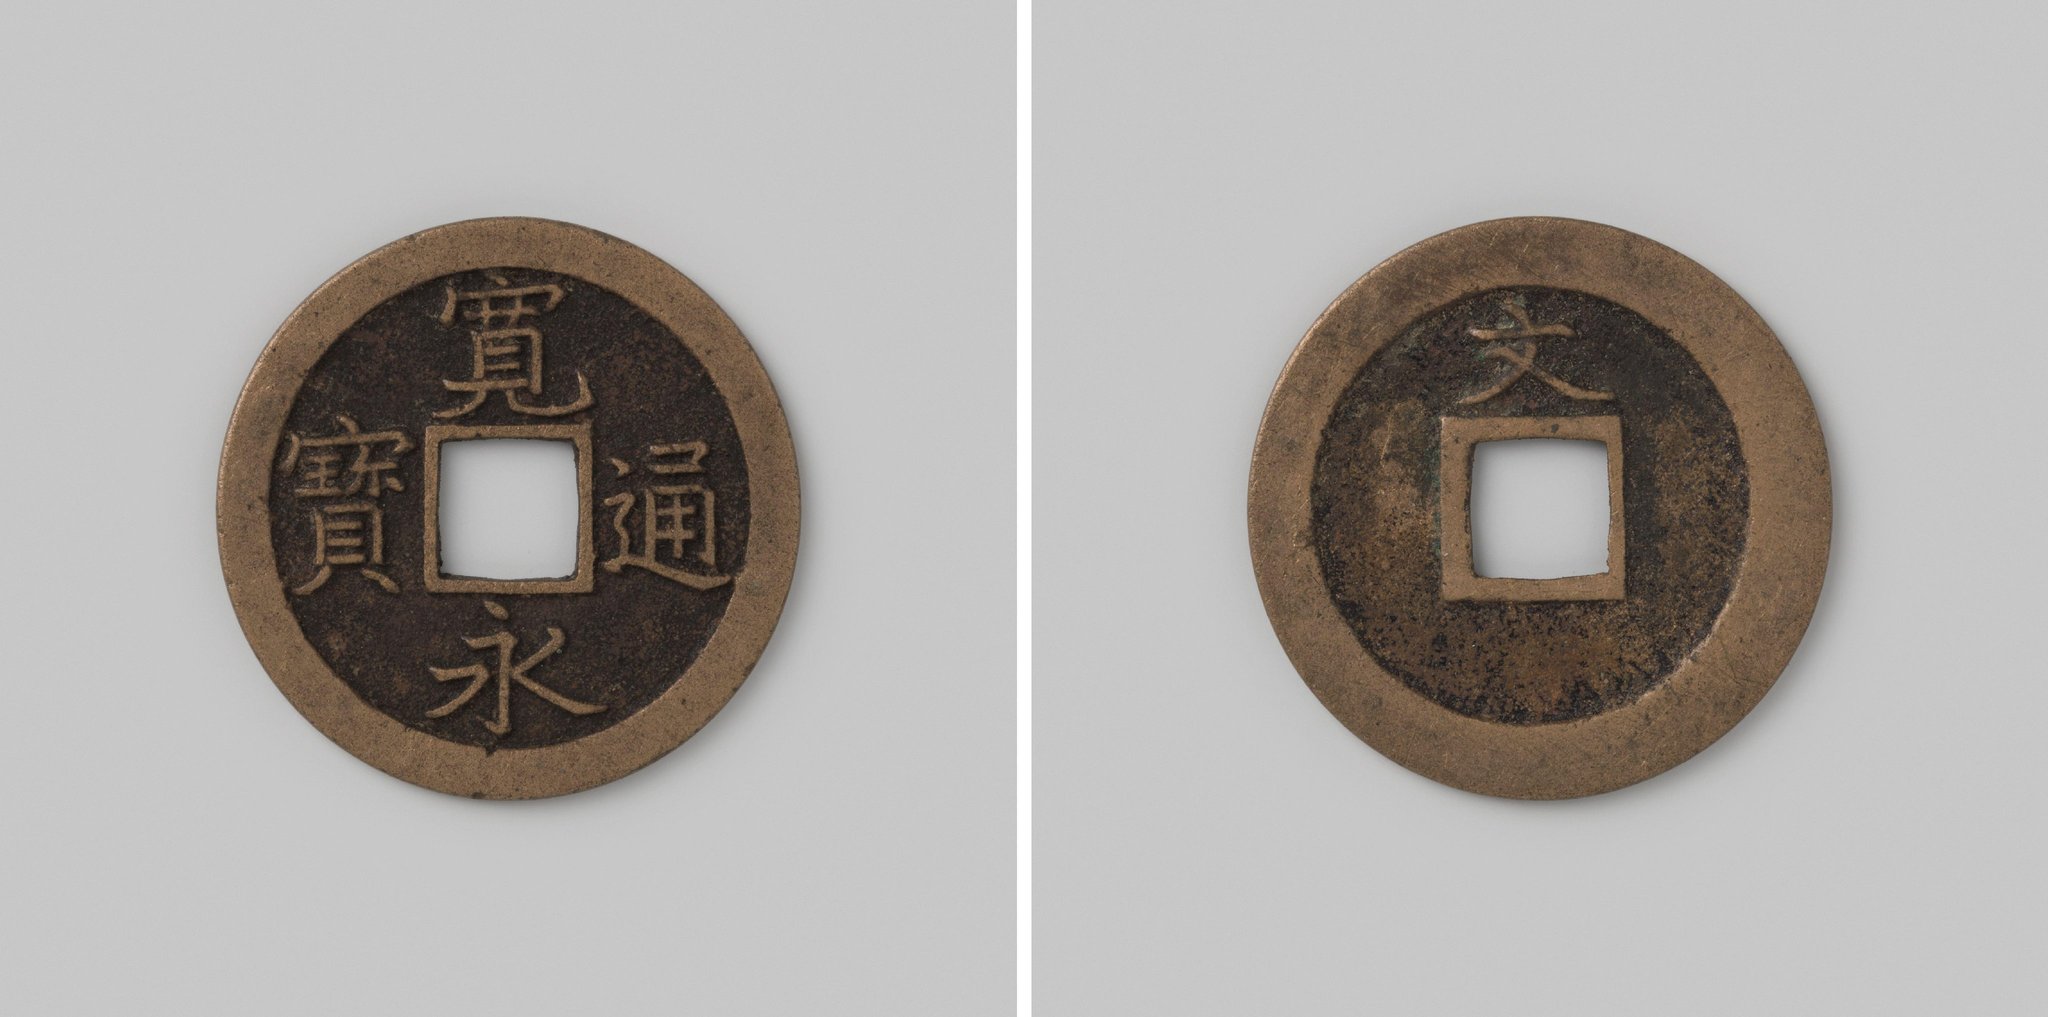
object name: mon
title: Keizerrijk Japan, kan'ei-tsūho (oude beschrijving: sen van 1 mon)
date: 1626-1739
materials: copper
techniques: casting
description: Koperen munt. Voorzijde: binnen brede gladde rand rondom vierkante uitsparing in het midden vier kruisgewijze geplaatste tekens met de betekenis: kanei tsuho [= kanei periode]. Keerzijde: binnen brde gladde rand glad oppervlak??